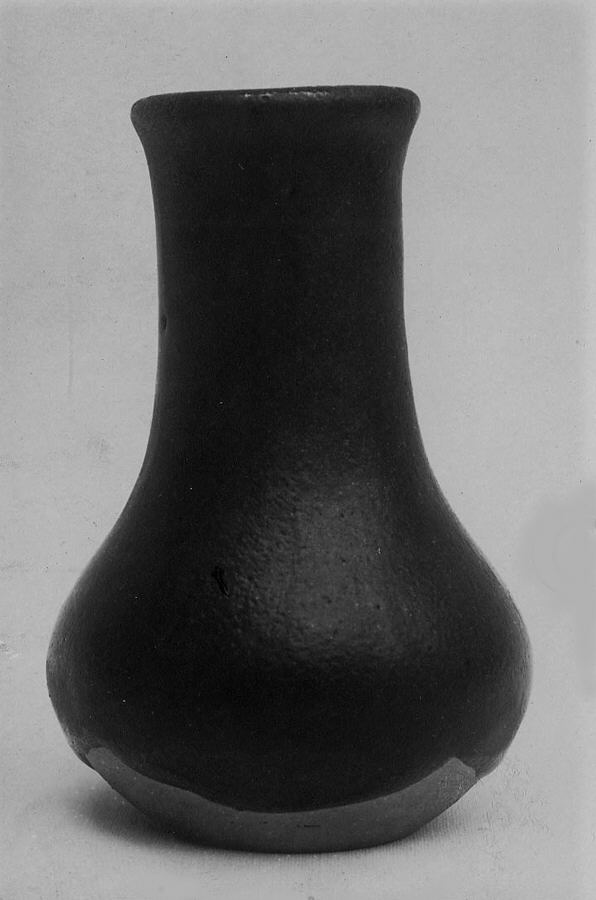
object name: tea jar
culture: japanese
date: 1700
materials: clay, glaze